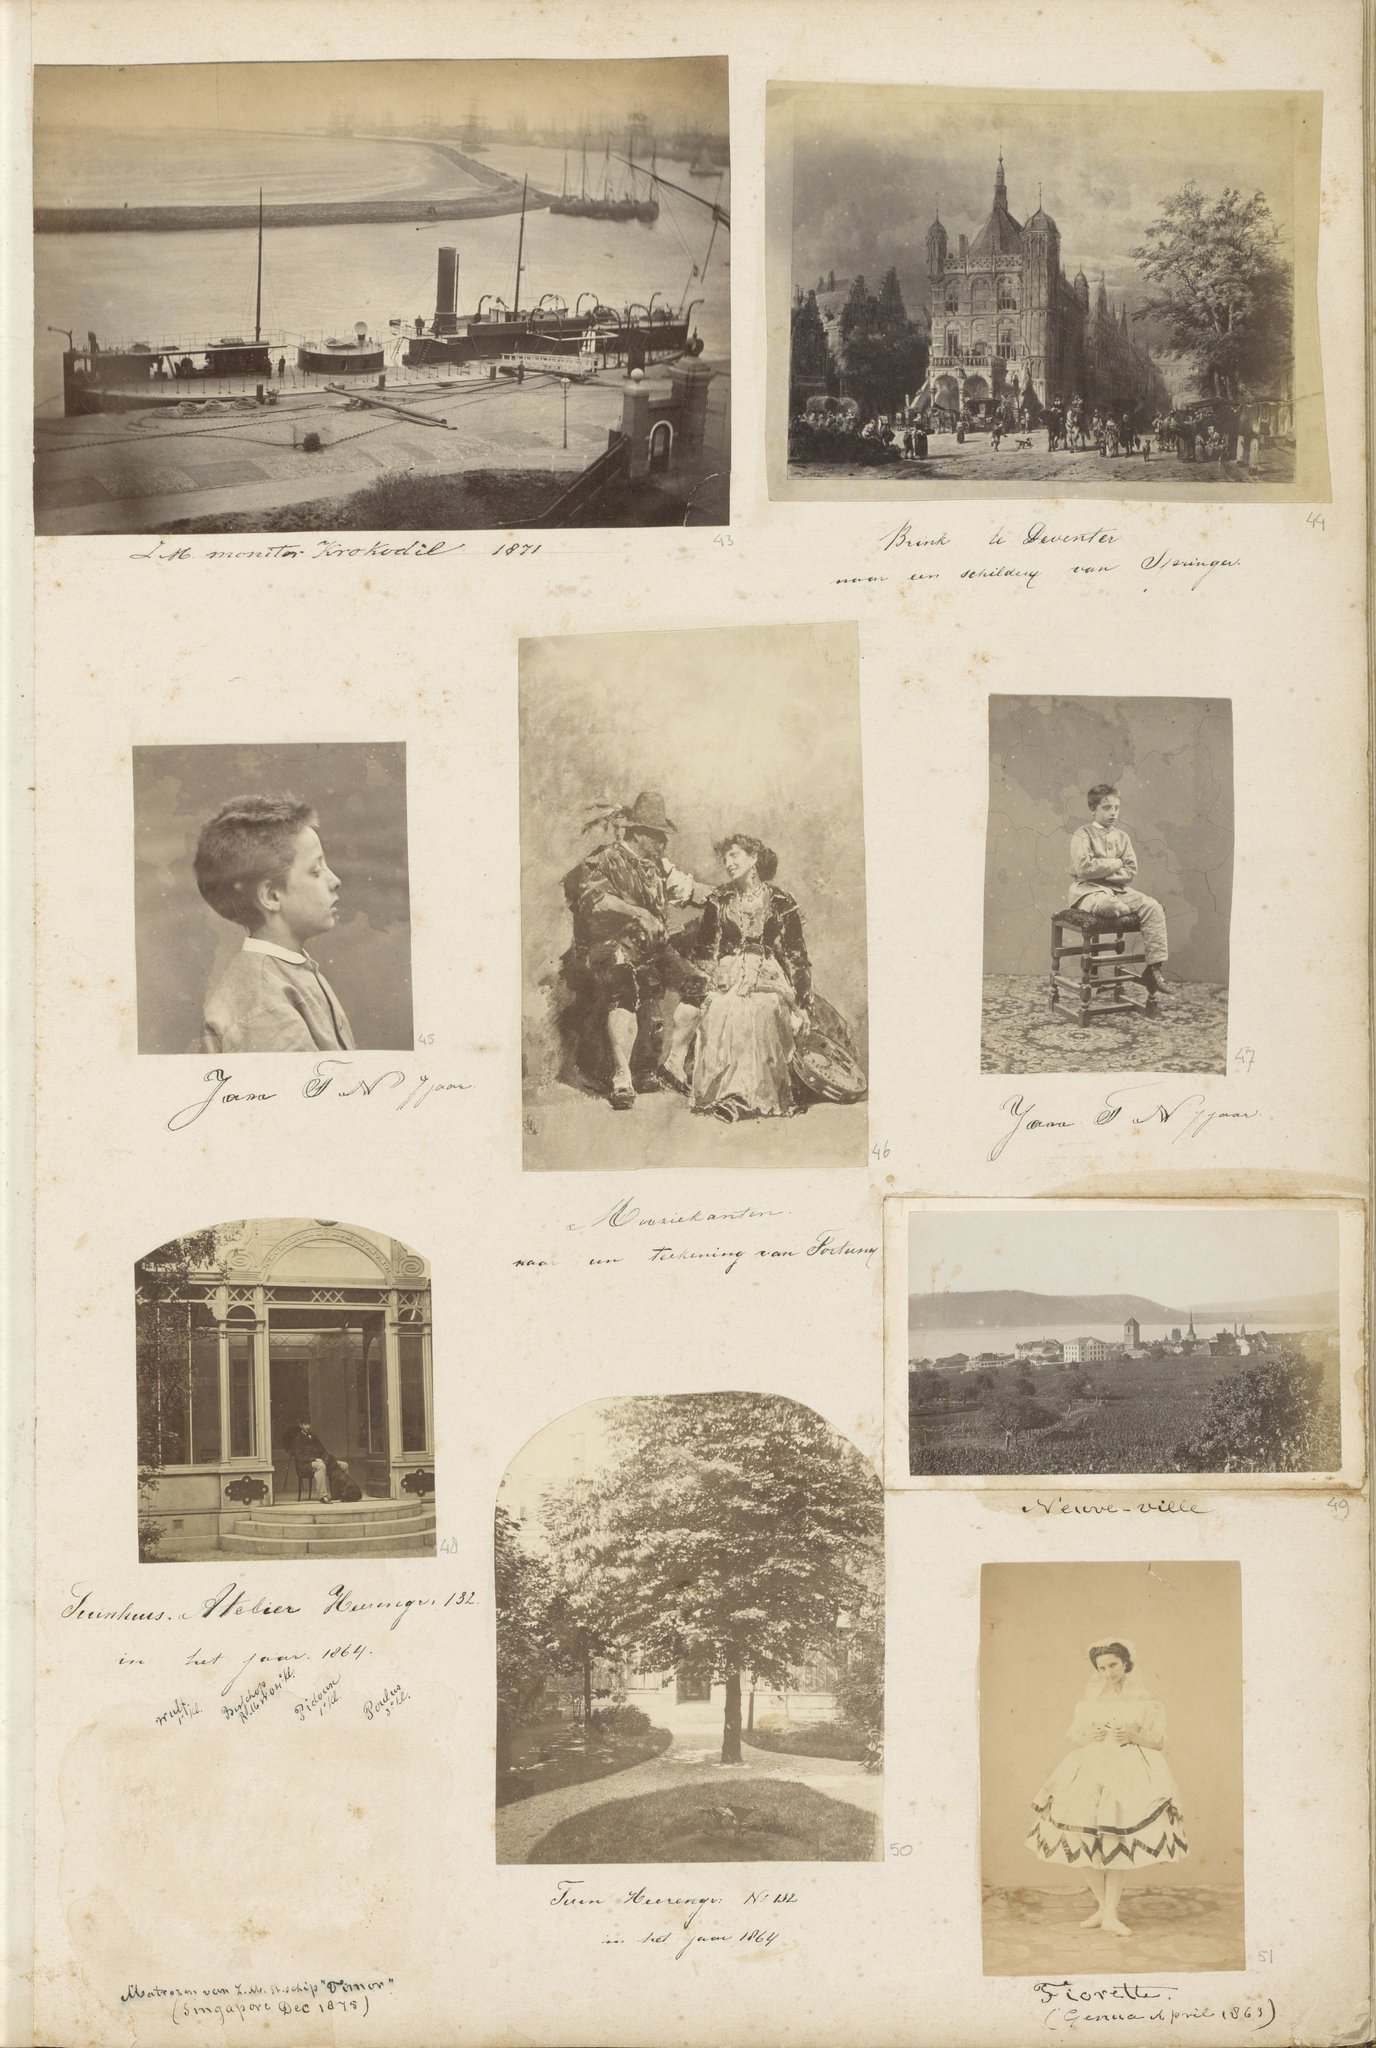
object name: photograph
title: Fotoreproductie van een tekening van Mariano José Maria Bernardo Fortuny y Carbó, voorstellend een man en een vrouw met een tamboerijn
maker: Anonymous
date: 1860-1870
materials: paper, photographic support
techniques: albumen print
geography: netherlands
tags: tambourine, couple of lovers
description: Onderdeel van Fotoalbum van Robert Daniel Crommelin (1841-1907).